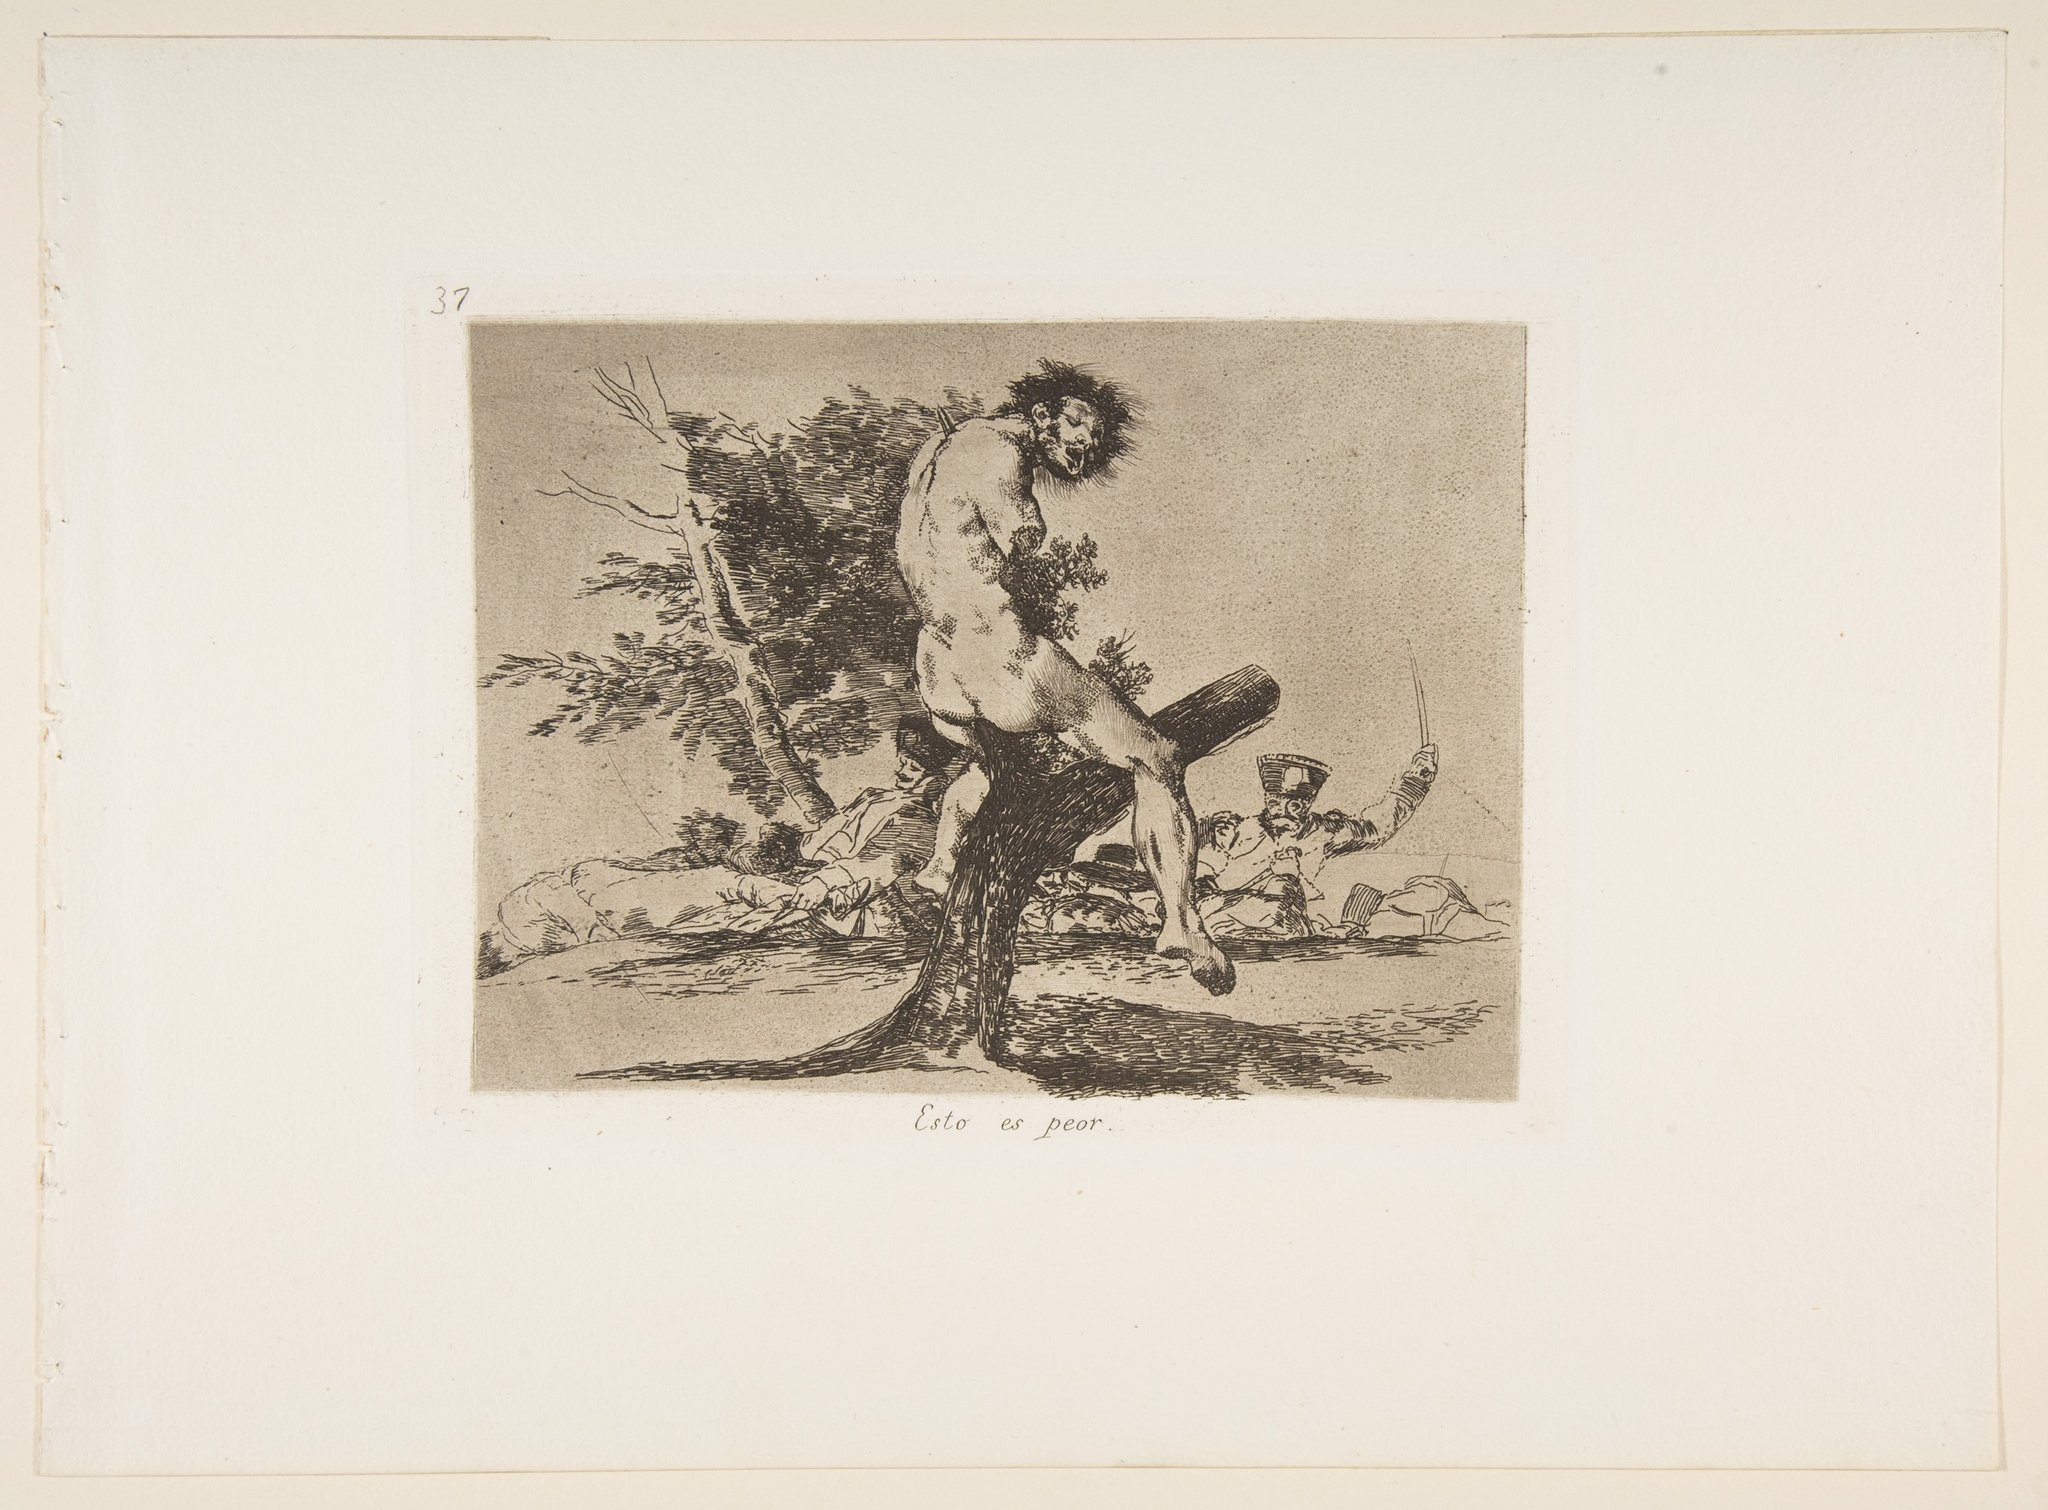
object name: print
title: Plate 37 from "The Disasters of War" (Los Desastres de La Guerra): This is worse (Esto es peor)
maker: goya (francisco de goya y lucientes)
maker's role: artist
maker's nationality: spanish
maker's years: 1746-1828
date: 1810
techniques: drypoint, etching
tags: male nudes,trees